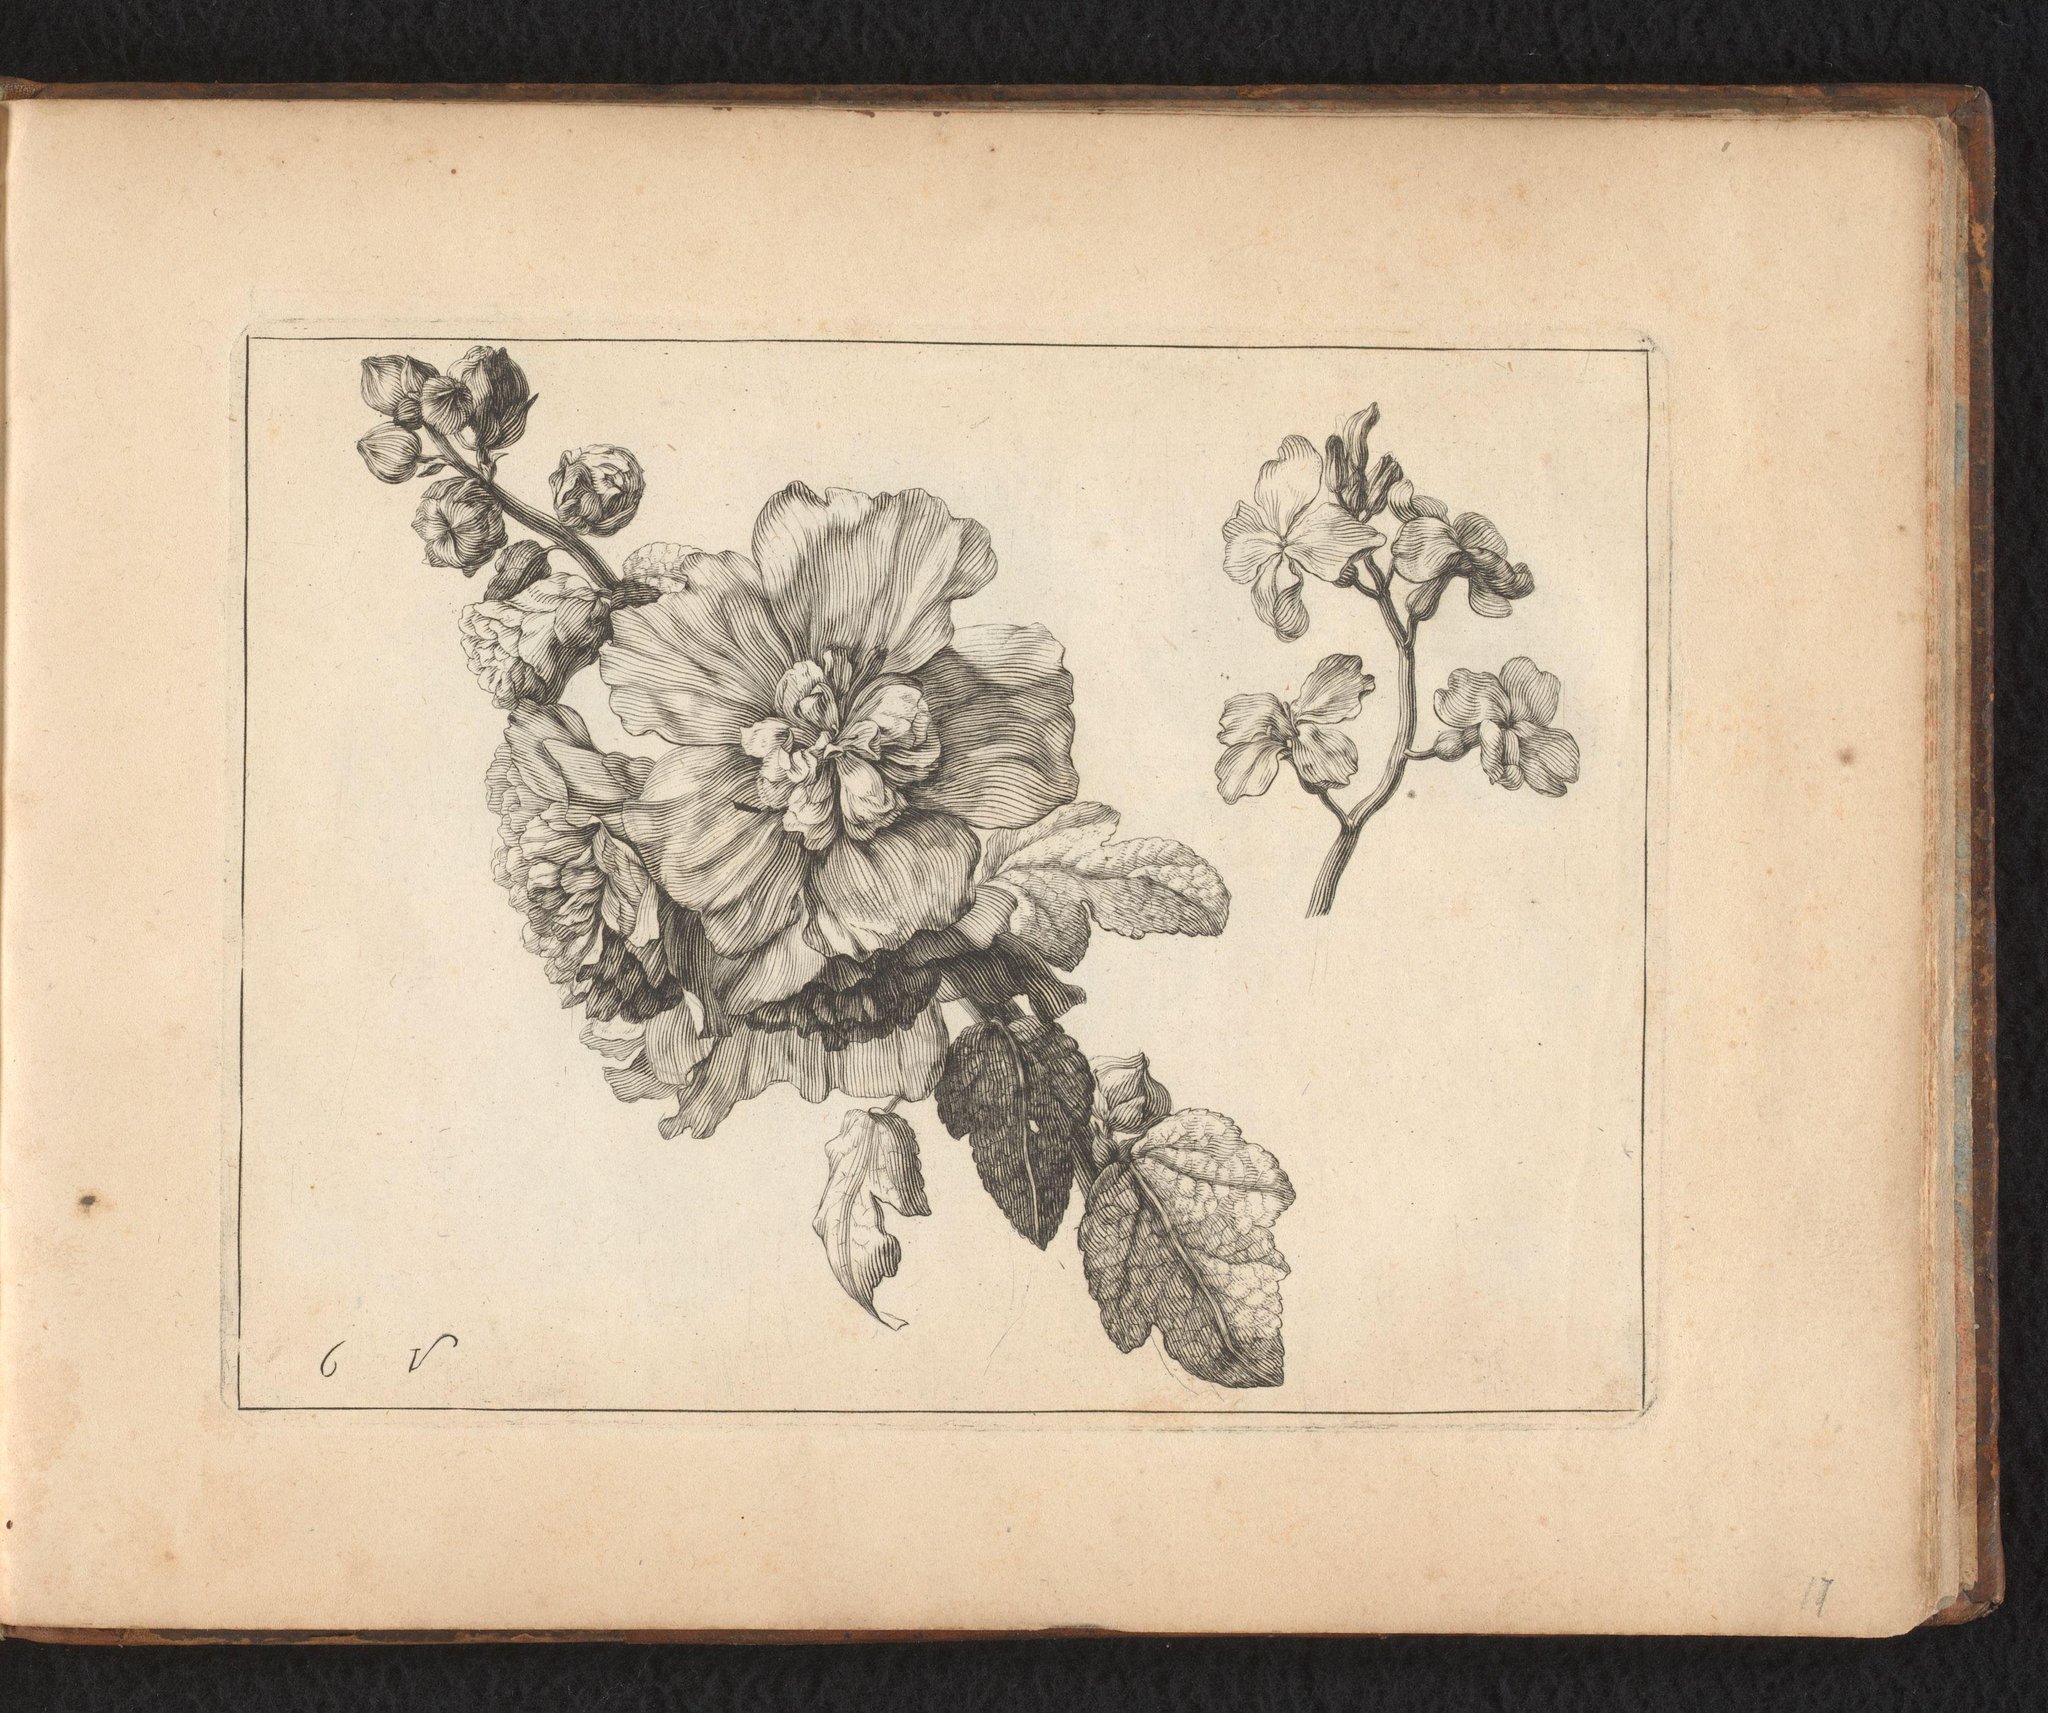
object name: album leaf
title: Verzameling van bloemen, elke soort in verschillende aspecten weergegeven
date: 1650-1676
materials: paper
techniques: engraving, etching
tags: flowers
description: Deze prent maakt deel uit van een album.